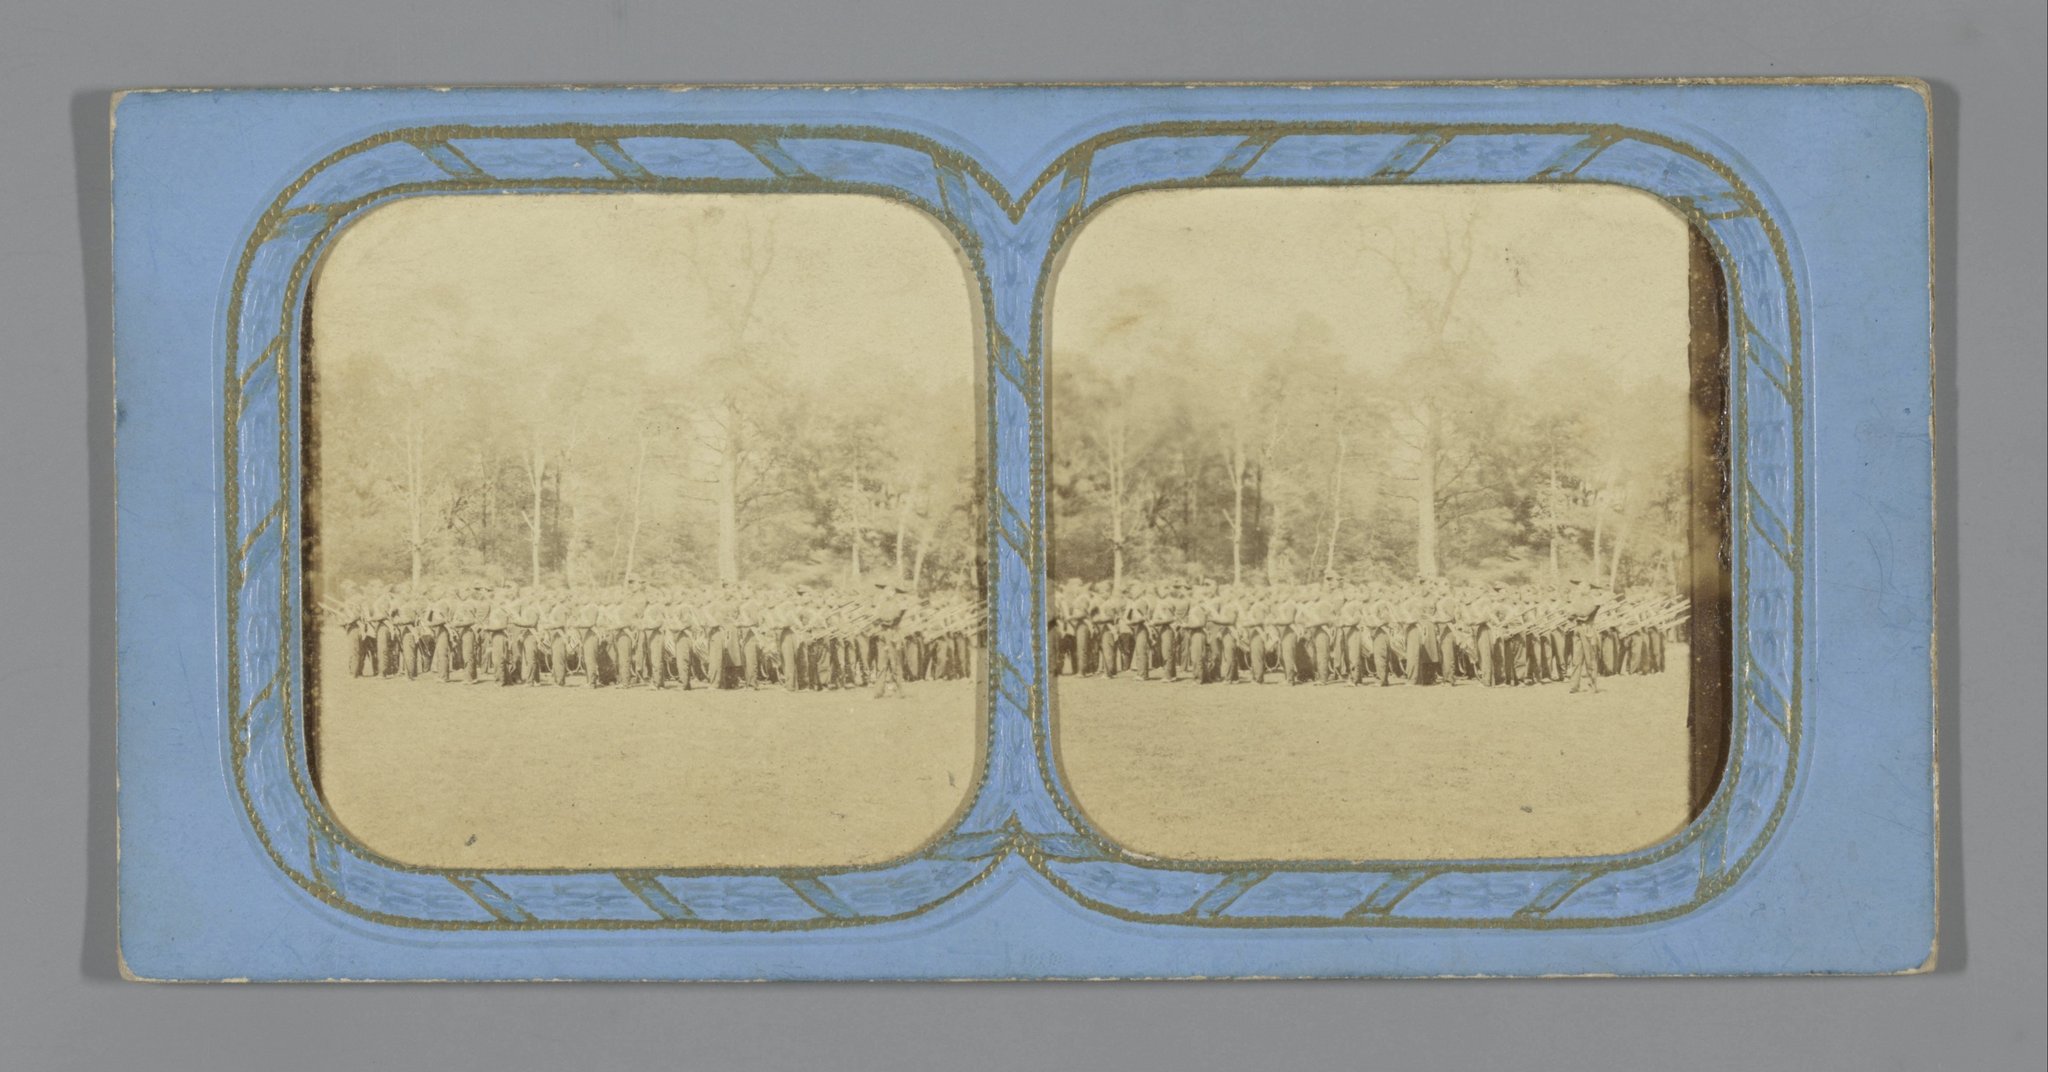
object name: tissue stereograph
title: Peloton soldaten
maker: Anonymous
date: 1855-1875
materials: cardboard, paper, photographic support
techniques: albumen print, cutting, hand coloring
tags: the soldier; the soldier's life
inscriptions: number: ‘16.’